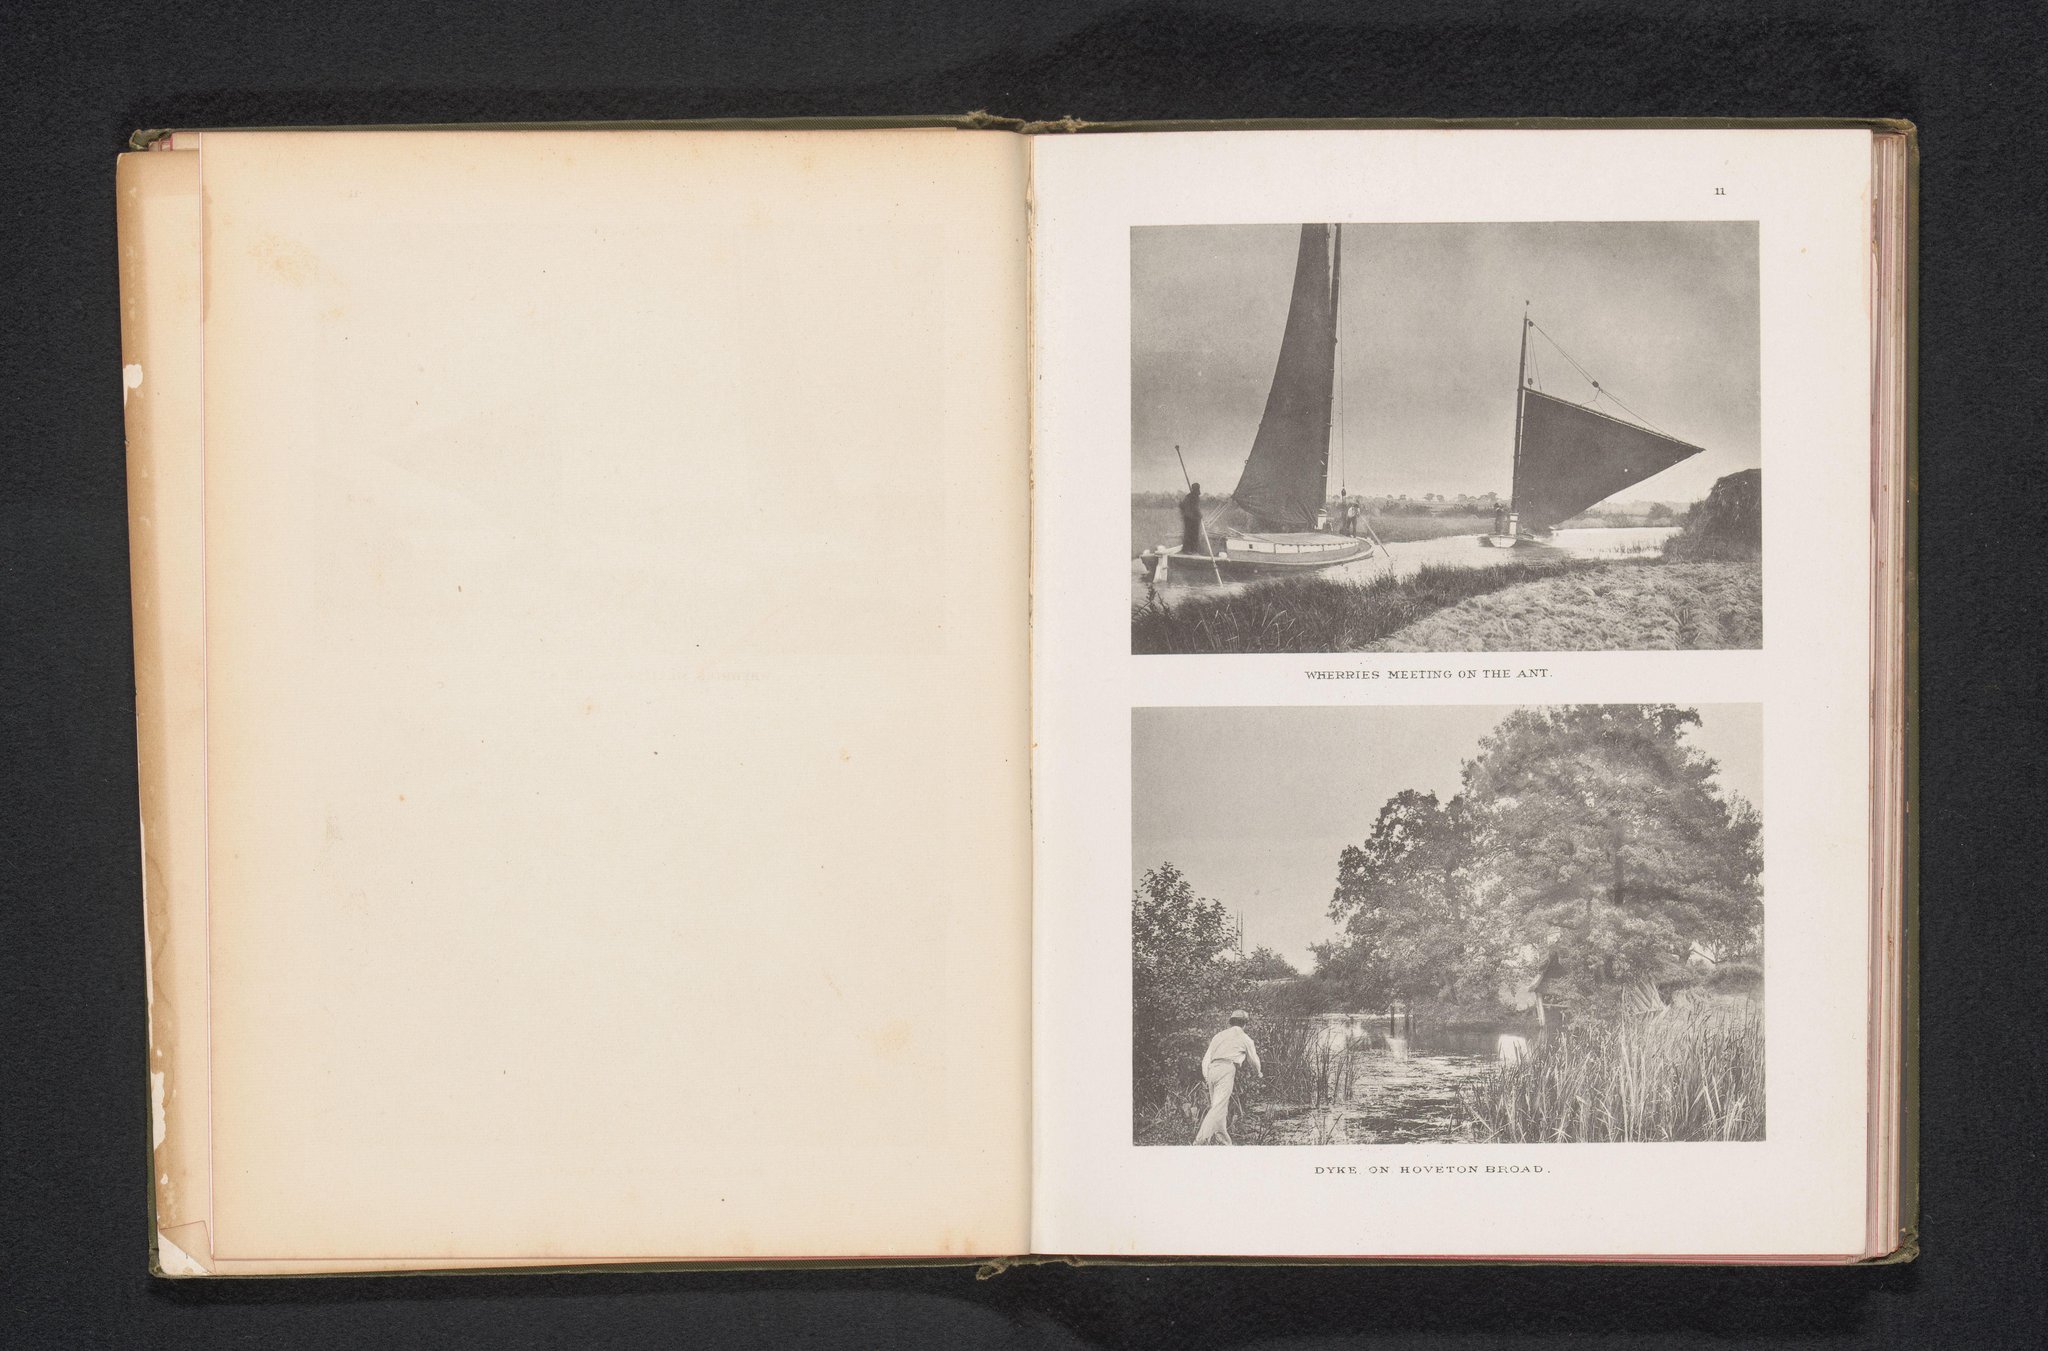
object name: page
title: Varende wherries op de Norfolk Broads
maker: john payne jennings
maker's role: fotograaf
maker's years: 1843-1926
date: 1886-1891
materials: paper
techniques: photograph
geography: surrey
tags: sailing-ship, sailing-boat, landscapes with waters, waterscapes, seascapes (in the temperate zone)